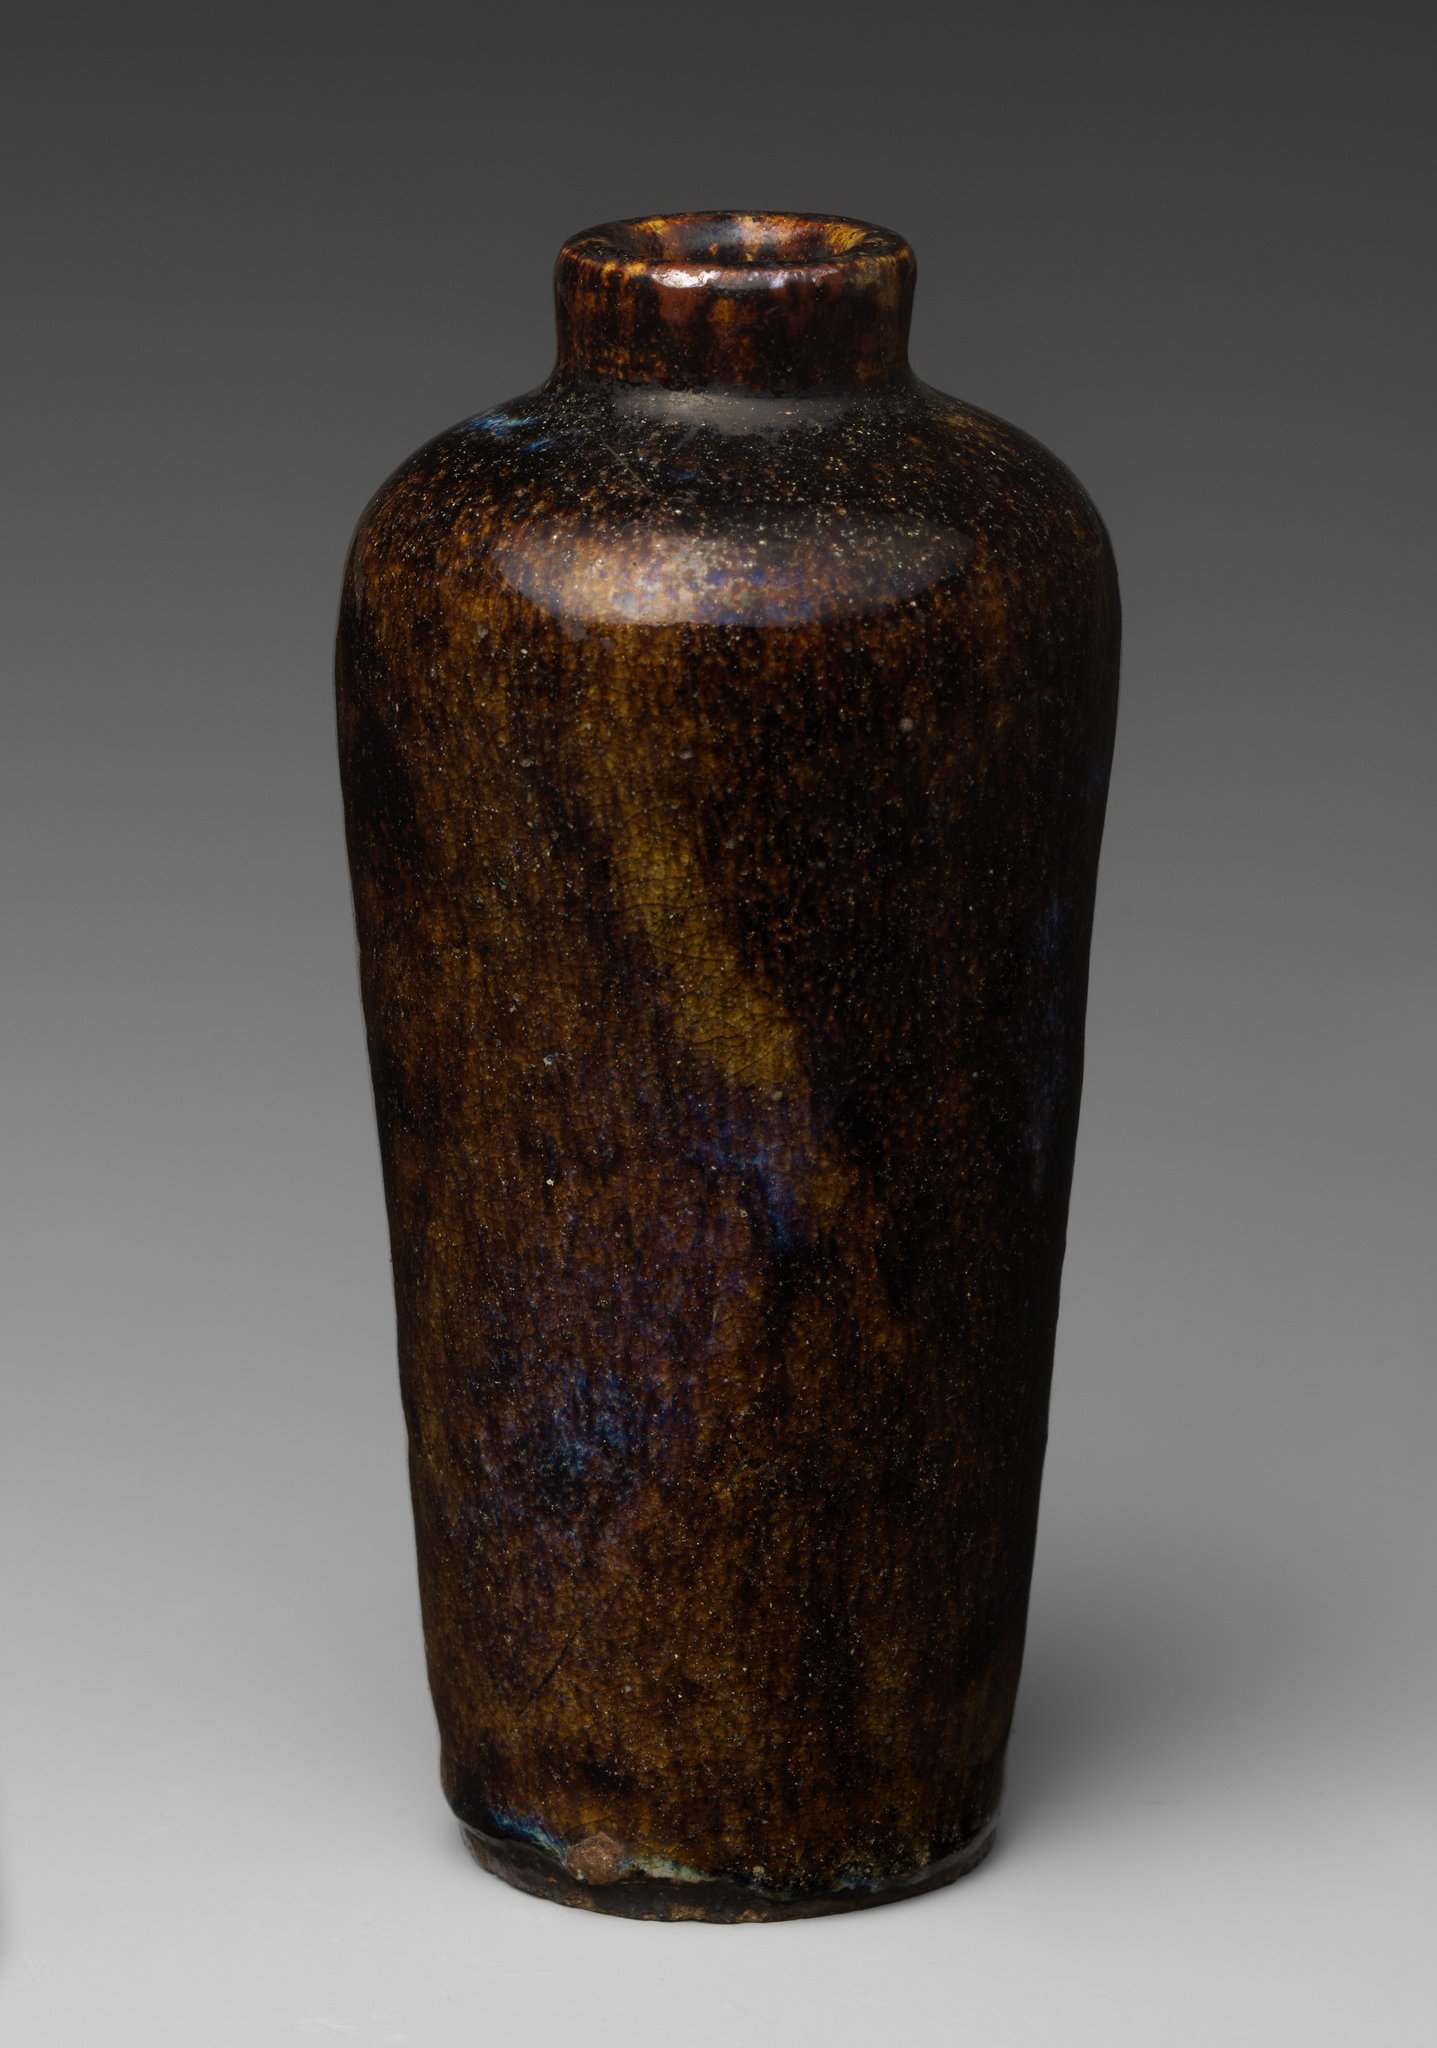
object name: vase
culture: japanese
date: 1767-1800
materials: glaze, pottery